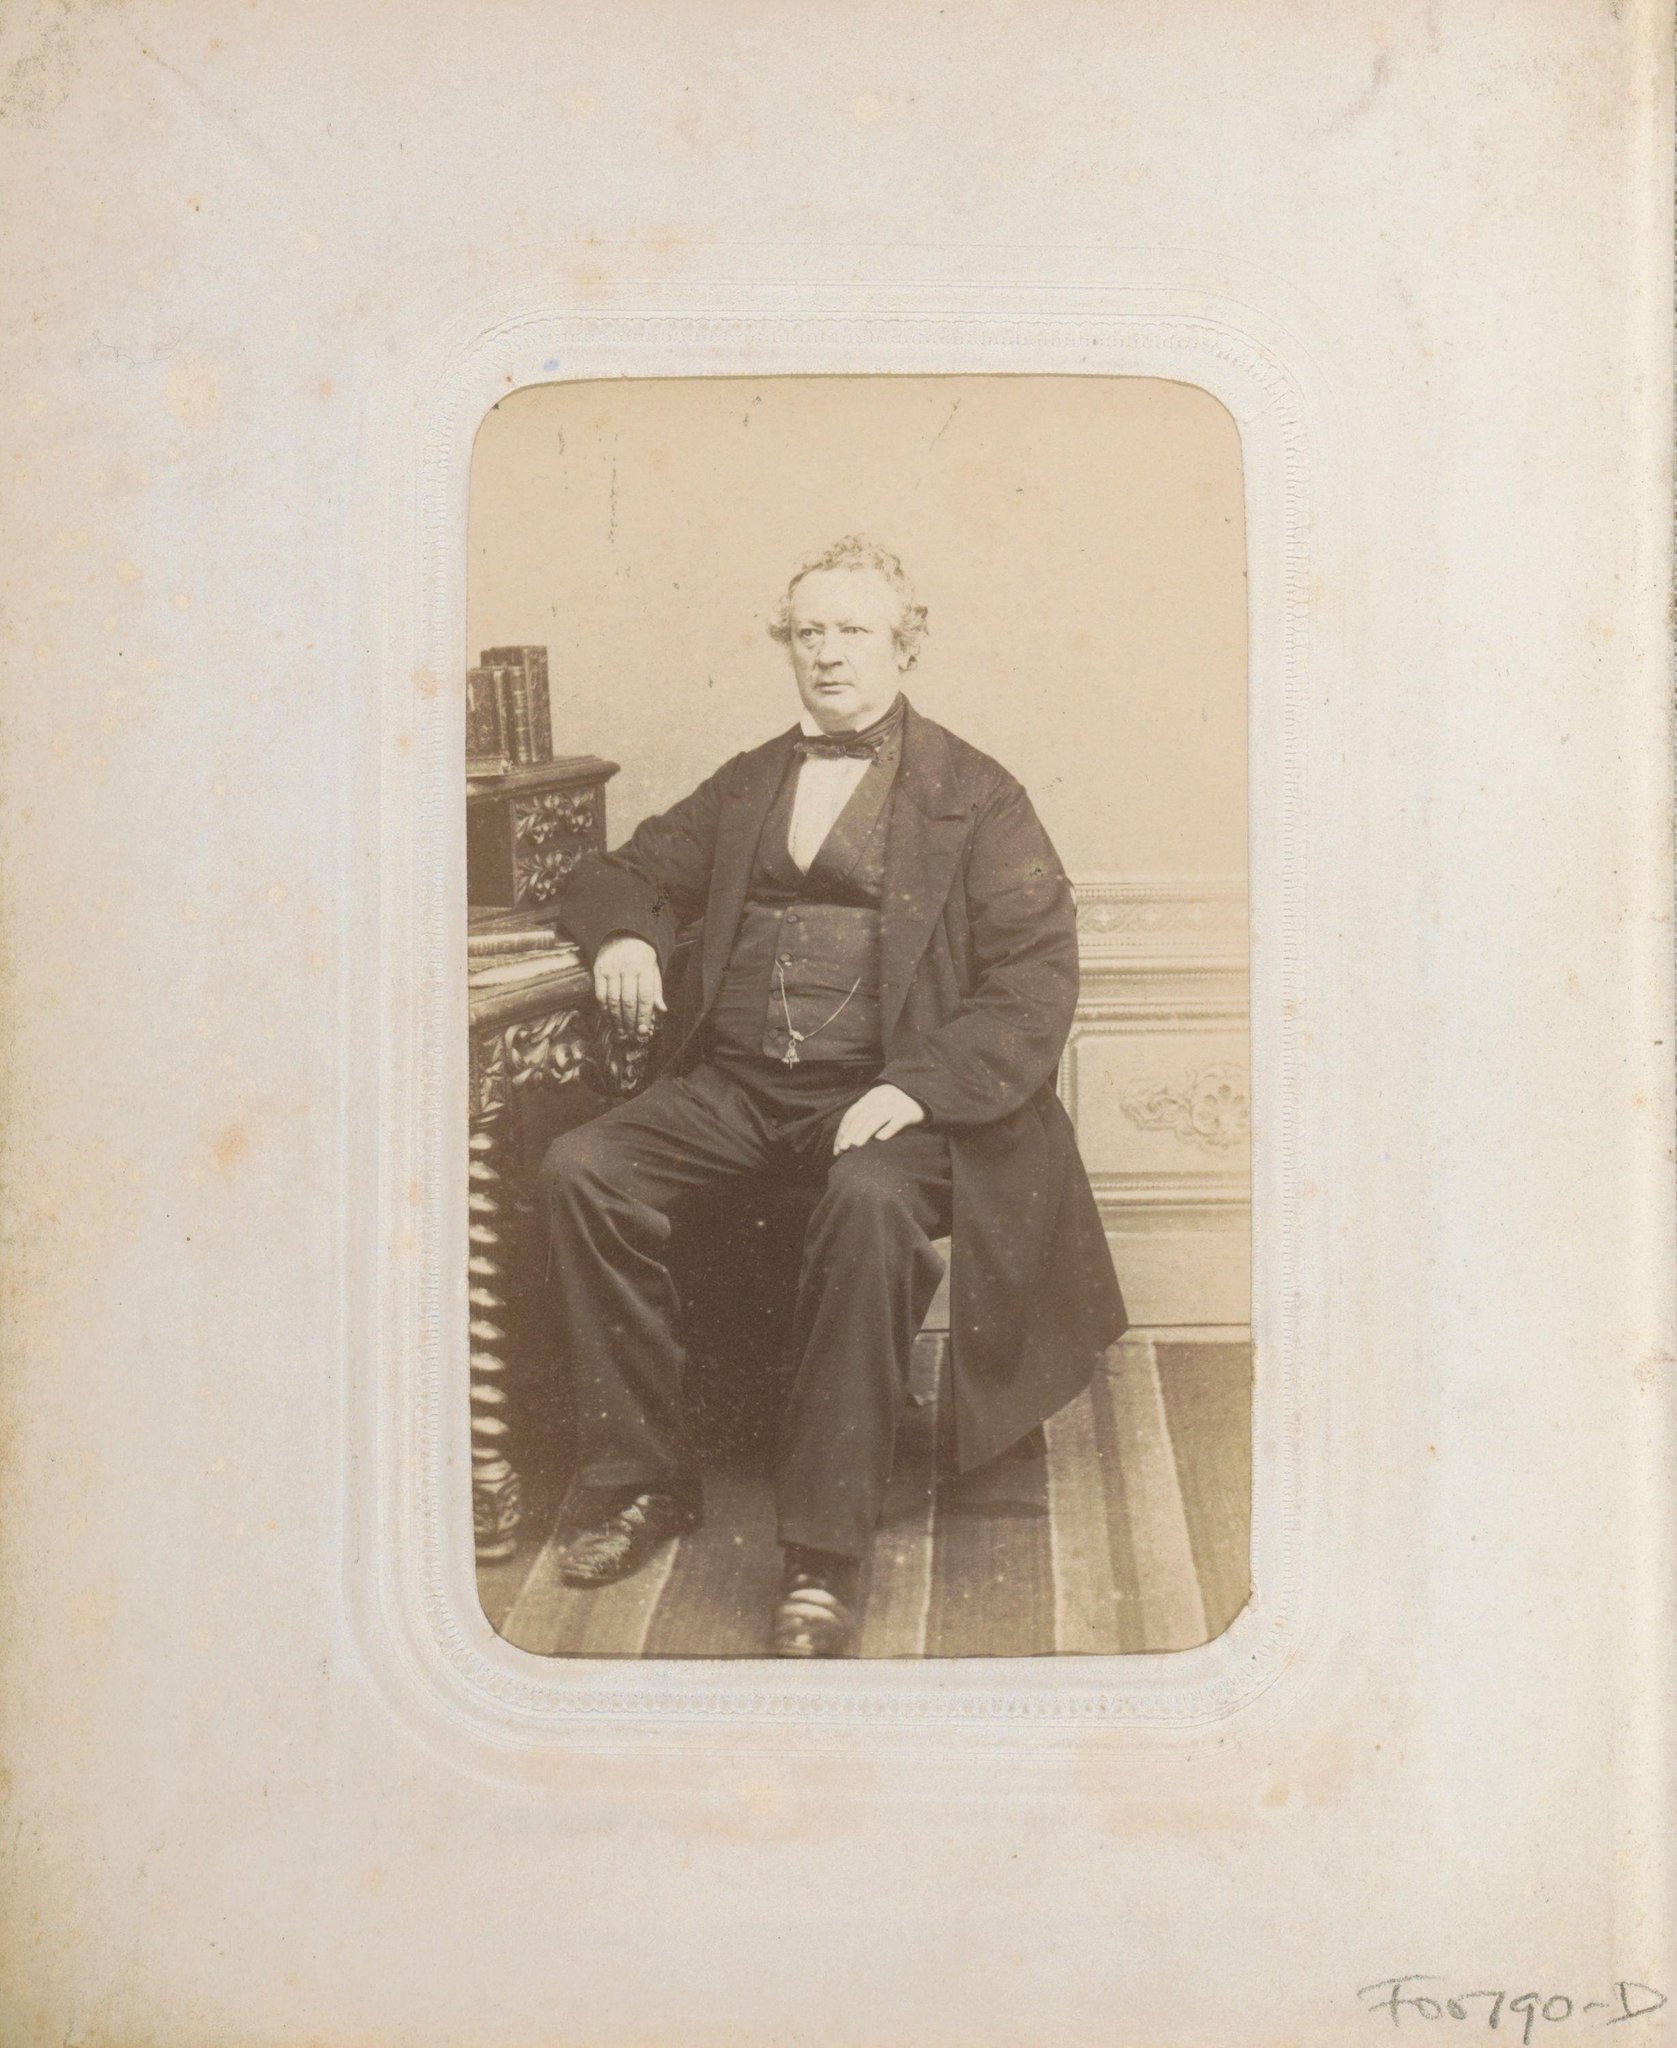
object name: photograph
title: Portret van een man met een jas, zittend aan een bureau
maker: egide verhassel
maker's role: fotograaf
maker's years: 1834-1921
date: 1860-1880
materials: cardboard, paper, photographic support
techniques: albumen print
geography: diest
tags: studio requisites ~ photographer, coat, cape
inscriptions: address: ‘Rue Neuve 43 Diest’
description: Onderdeel van Fotoalbum met 26 cartes-de-visite van rooms-katholieke geestelijken.